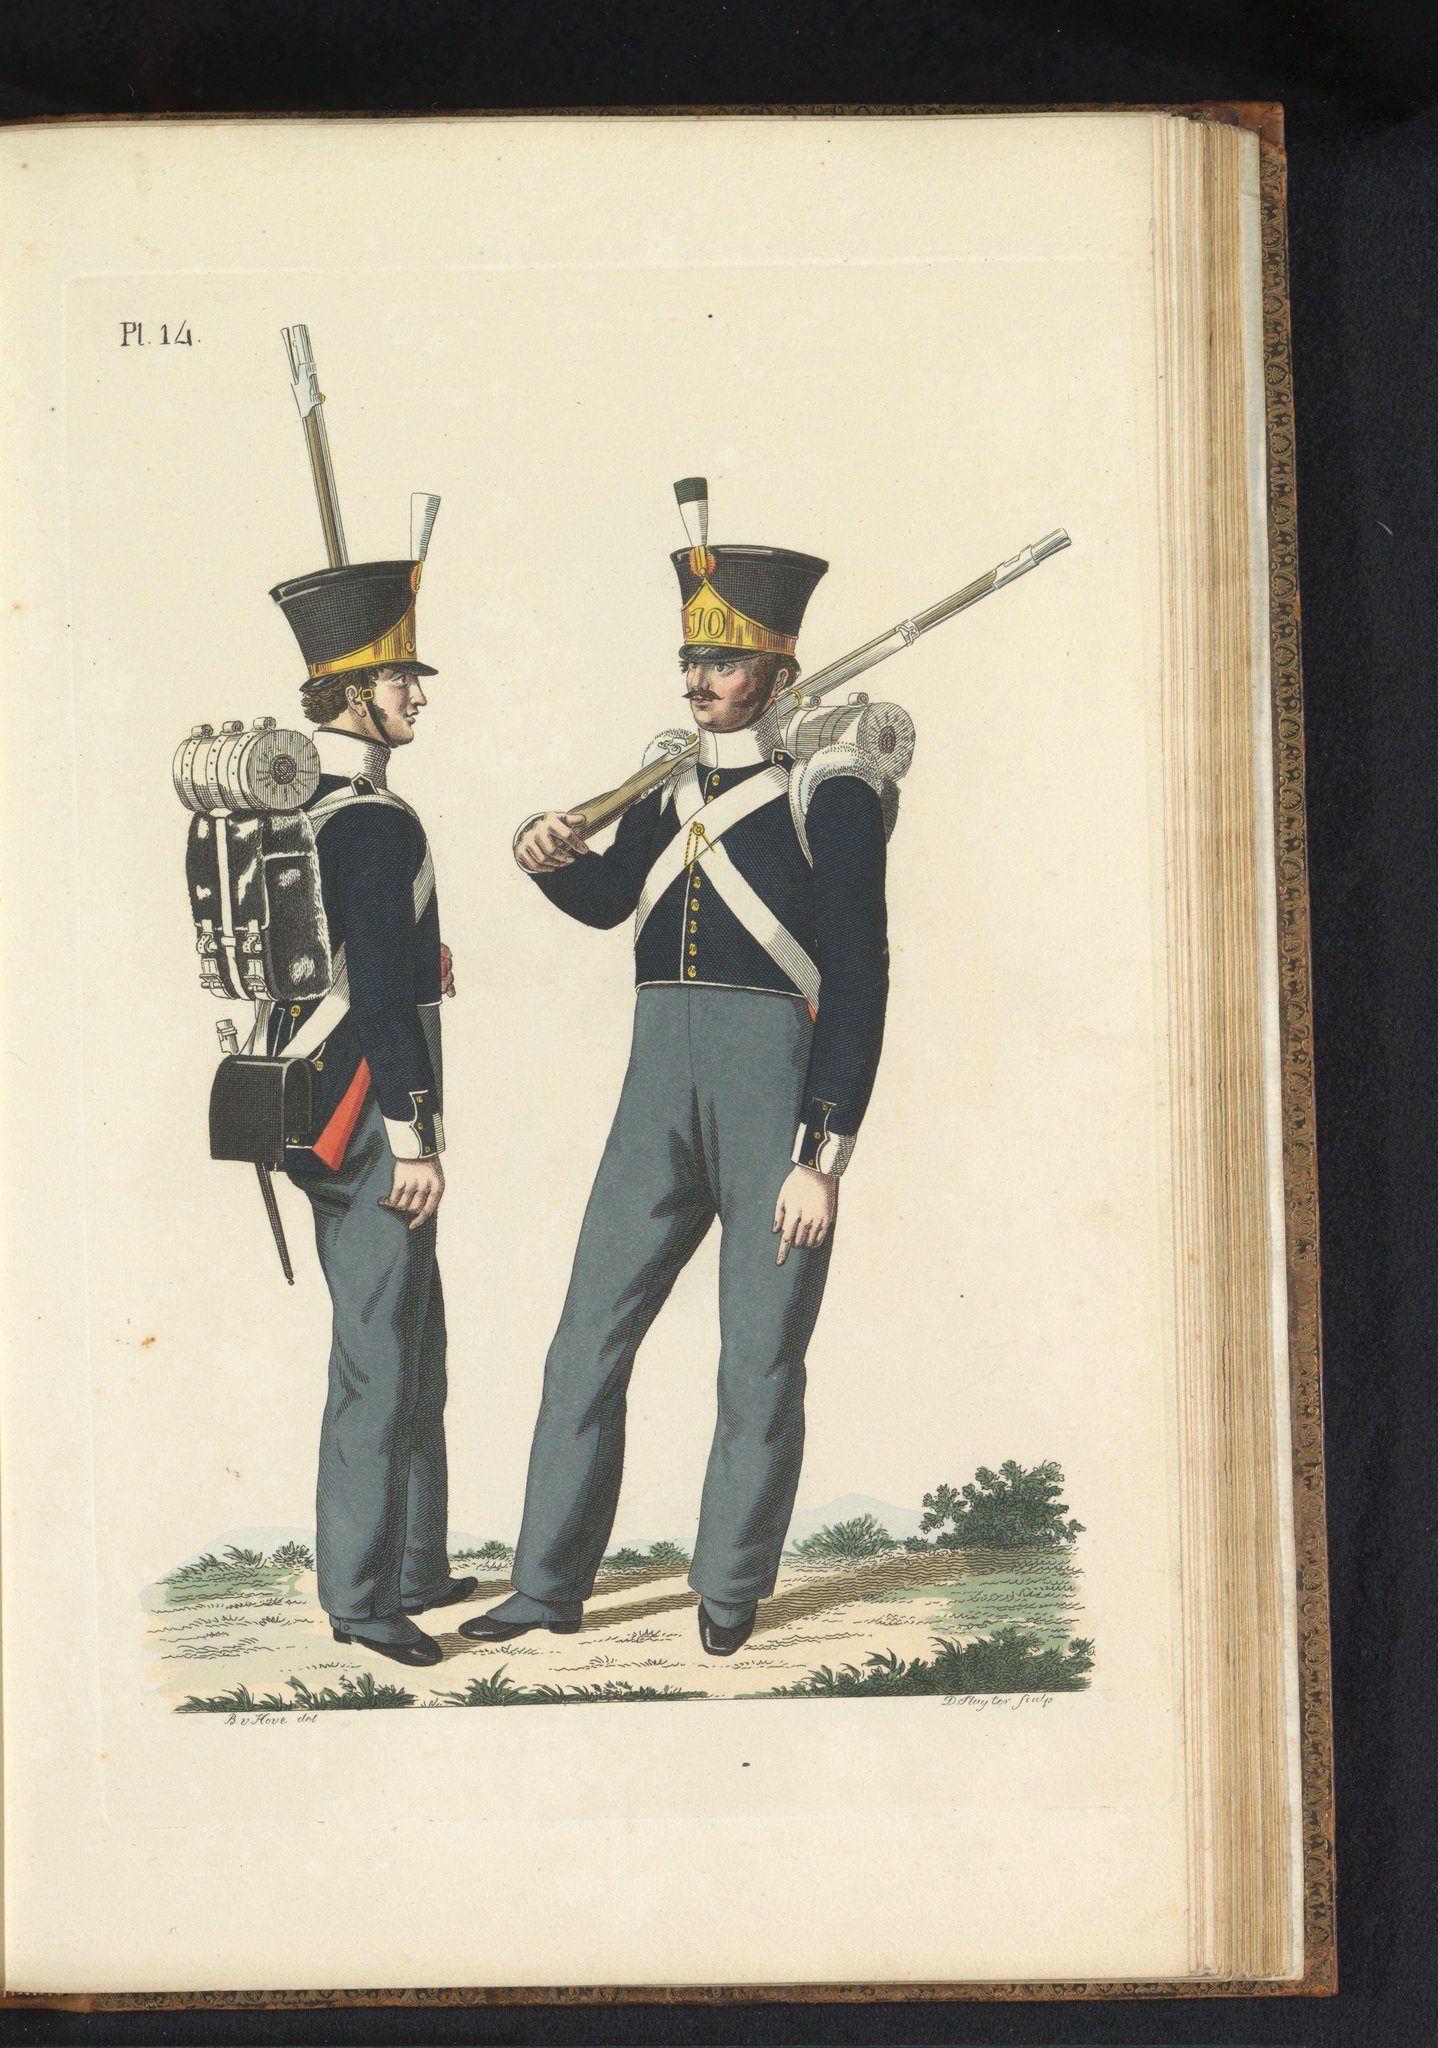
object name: print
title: Flankeur en Fuselier, der Nationale Infanterie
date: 1823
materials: paper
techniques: engraving, etching, hand coloring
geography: the hague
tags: (military) uniforms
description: Een Nederlandse flankeur en een fuselier van het 10e regiment van de Nationale Infanterie, van voren en op de rug gezien. Plaat 14. Uniformvoorstelling in 'Beschrijving hoedanig de Koninklijke Nederlandsche troepen' van J.F. Teupken, 1823.